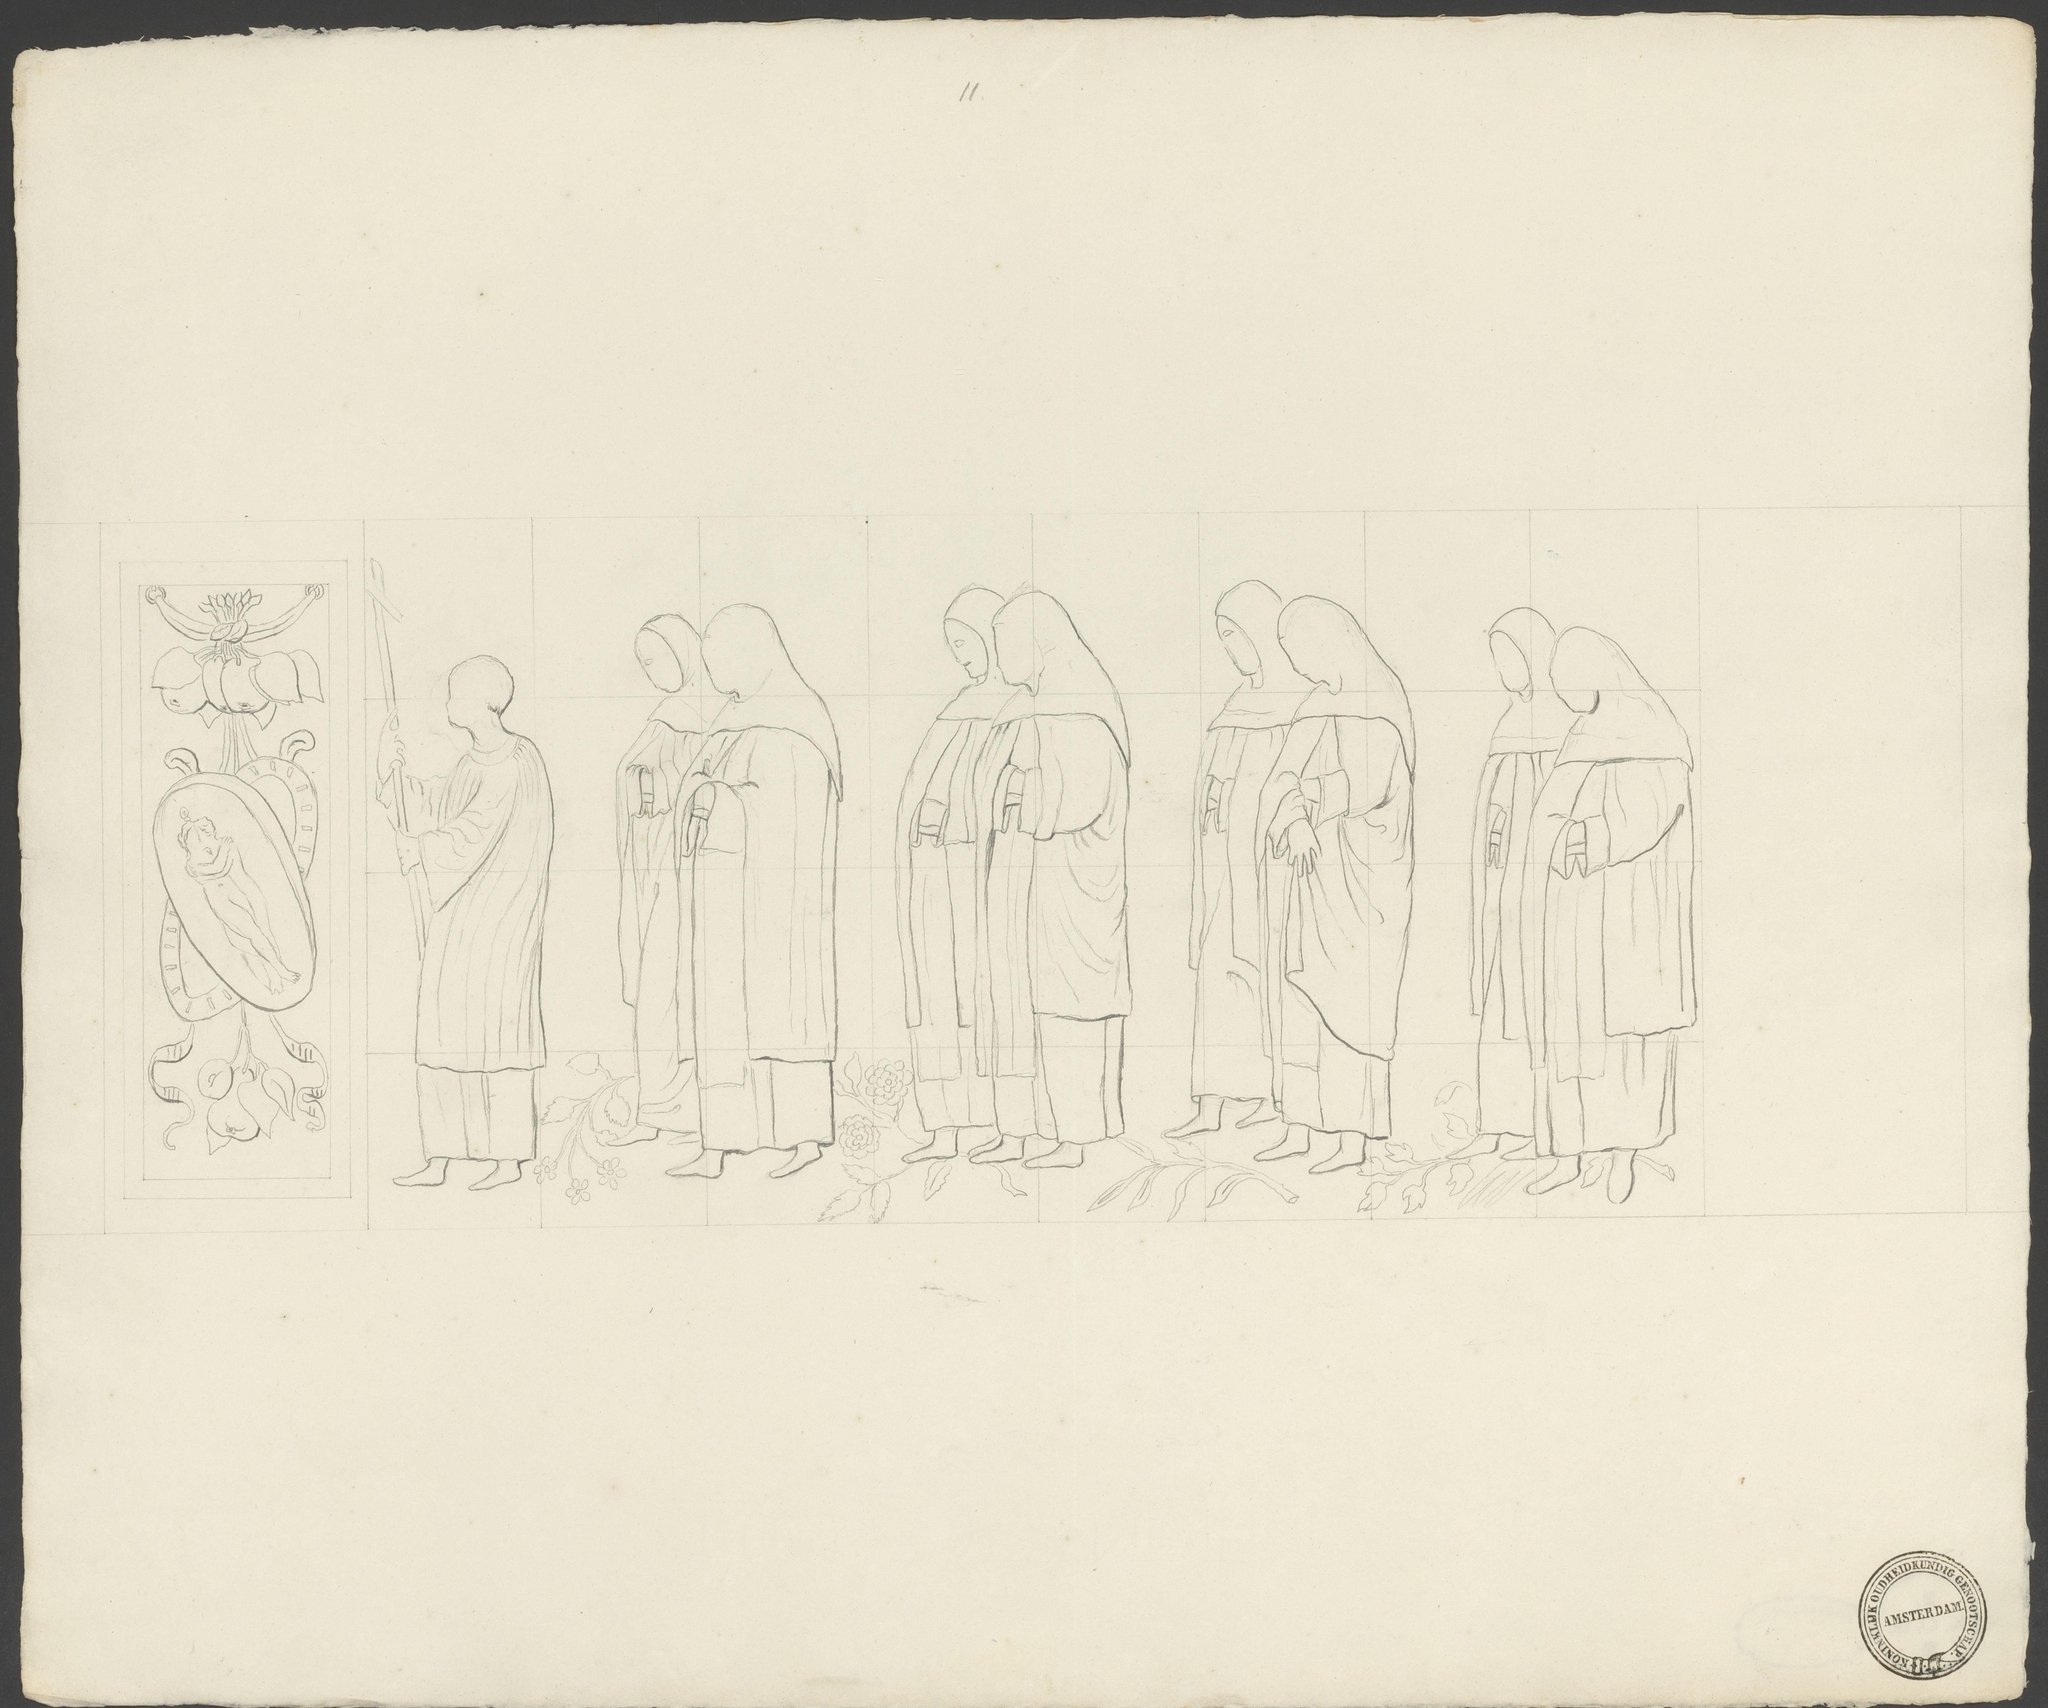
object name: drawing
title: Houtsnijwerk op de koorbanken in de Grote of Onze-Lieve-Vrouwekerk (Dordrecht)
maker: Anonymous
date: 1850-1940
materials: paper, pencil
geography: dordrecht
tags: carving ~ applied arts, piece of sculpture, reproduction of a piece of sculpture, wood carver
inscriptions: collector's mark, collector's mark: ‘Koninklijk Oudheidkundig Genootschap Amsterdam’, collector's mark: Lugt 1641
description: Paneel met monniken. Onderdeel van een serie van 18 schetstekeningen naar het houtsnijwerk gemaakt door Jan Aertsz. Terwen in de jaren 1538-1542 voor de koorbanken in de Grote of Onze-Lieve-Vrouwekerk te Dordrecht. Genummerd bovenaan: 11. Onderwerpsrubrieken binnen de Atlas Zeden en Gewoonten: Beeldhouw- en snijkunst.